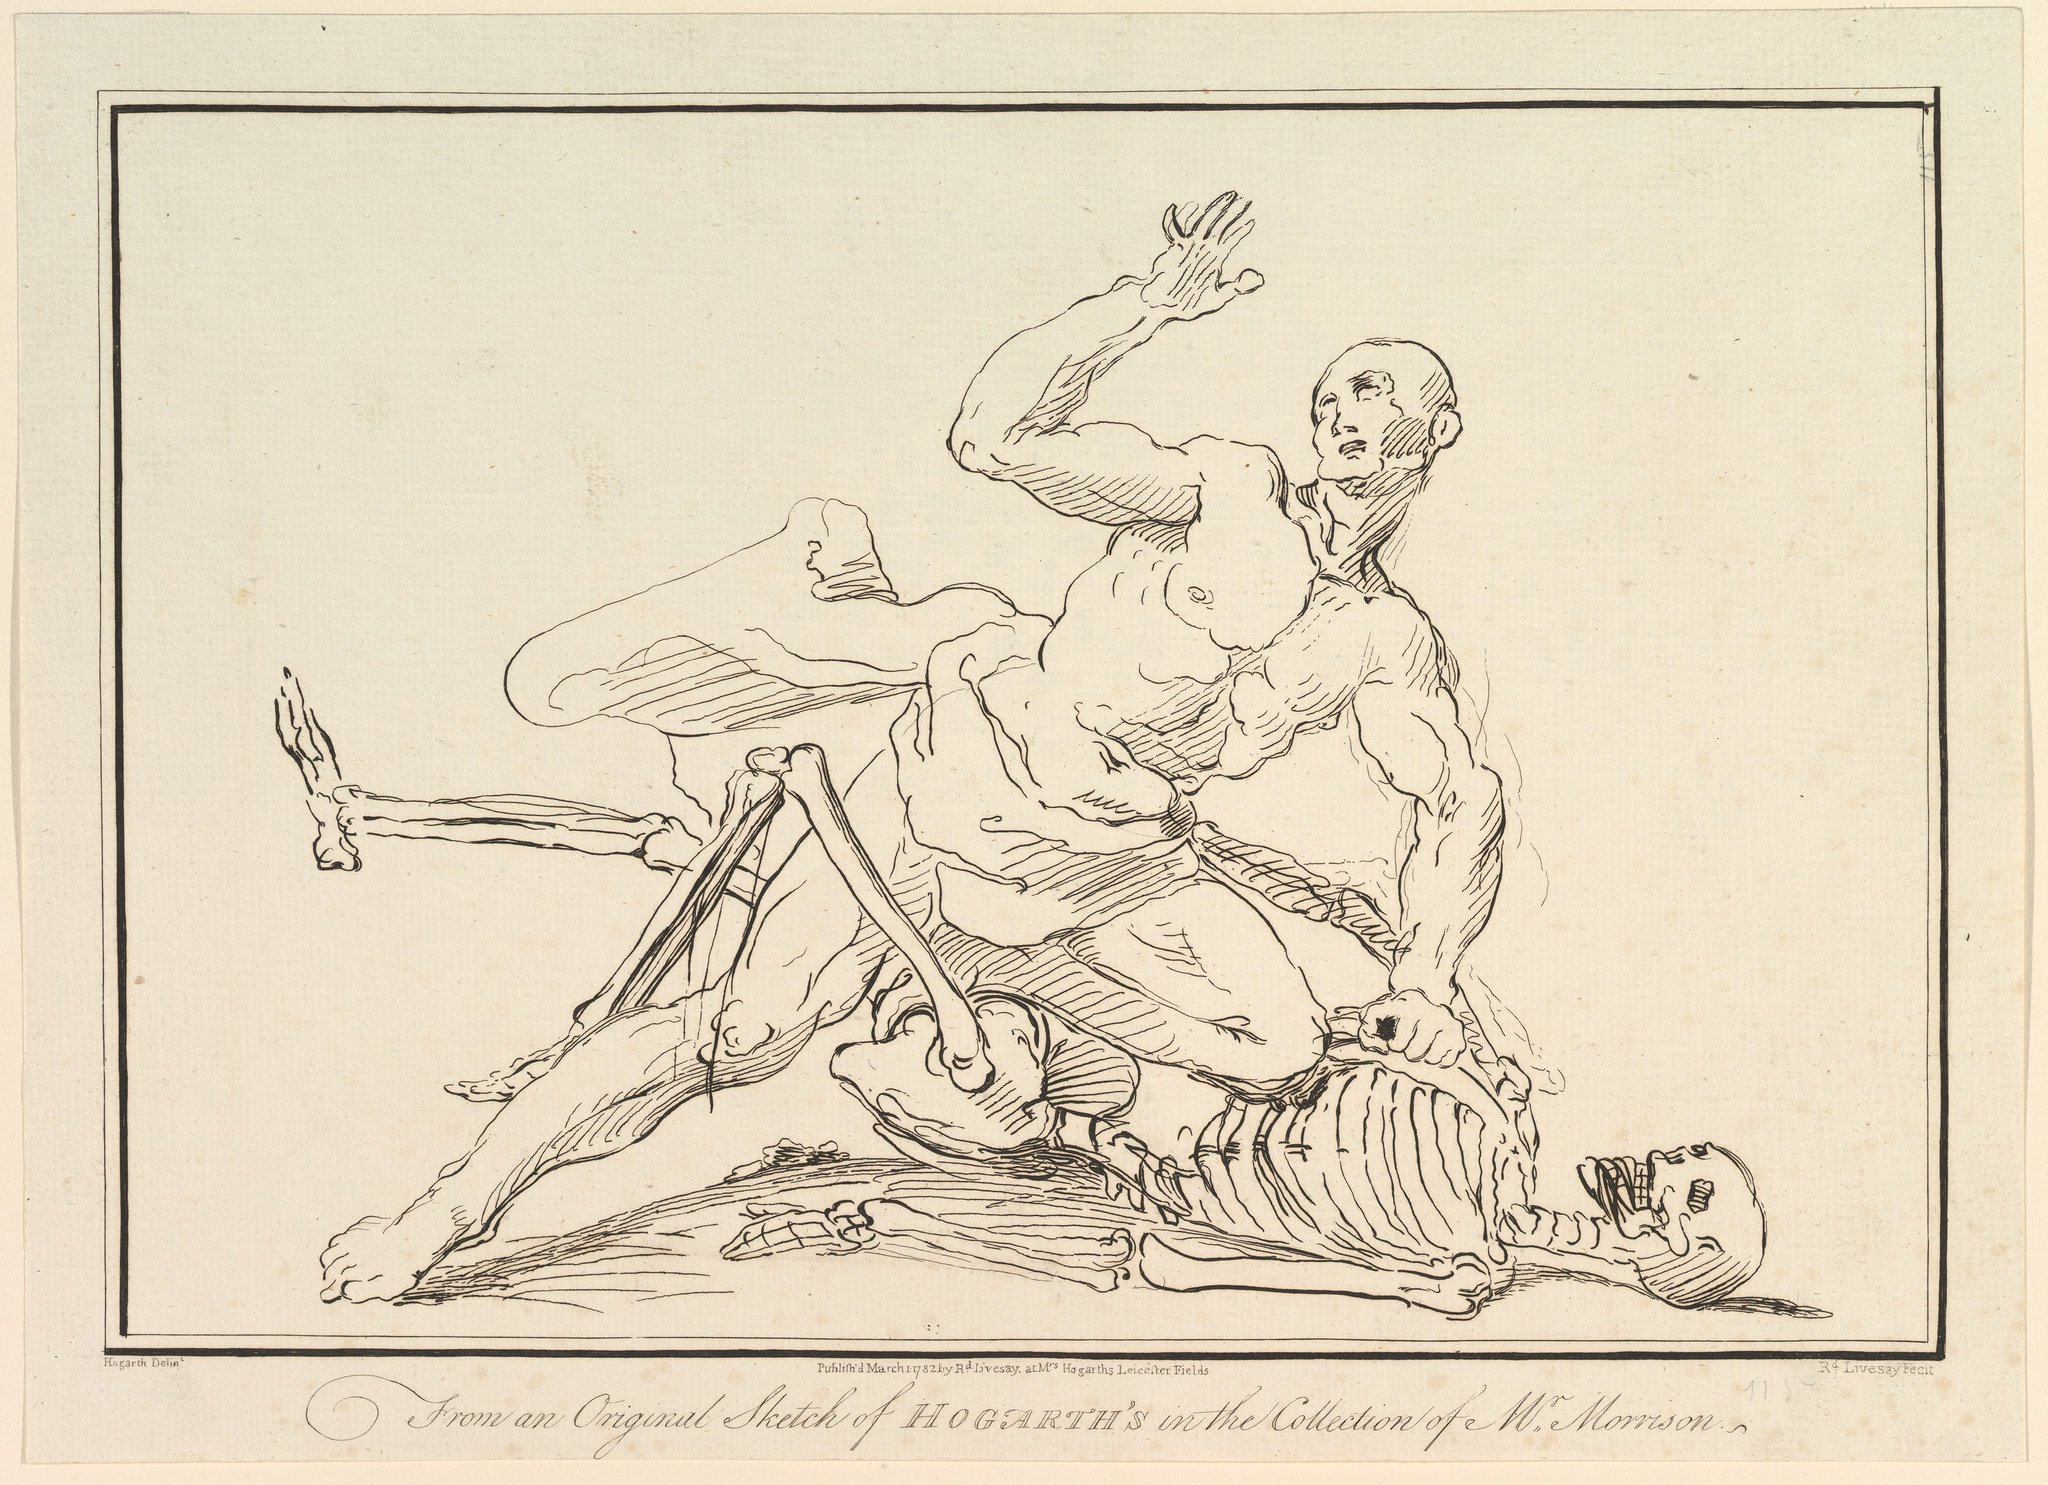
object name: print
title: From an Original Sketch of William Hogarth's in the Collection of Mr. Morrison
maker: richard livesay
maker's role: artist and publisher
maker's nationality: british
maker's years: 1750-1826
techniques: etching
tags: skeletons,men